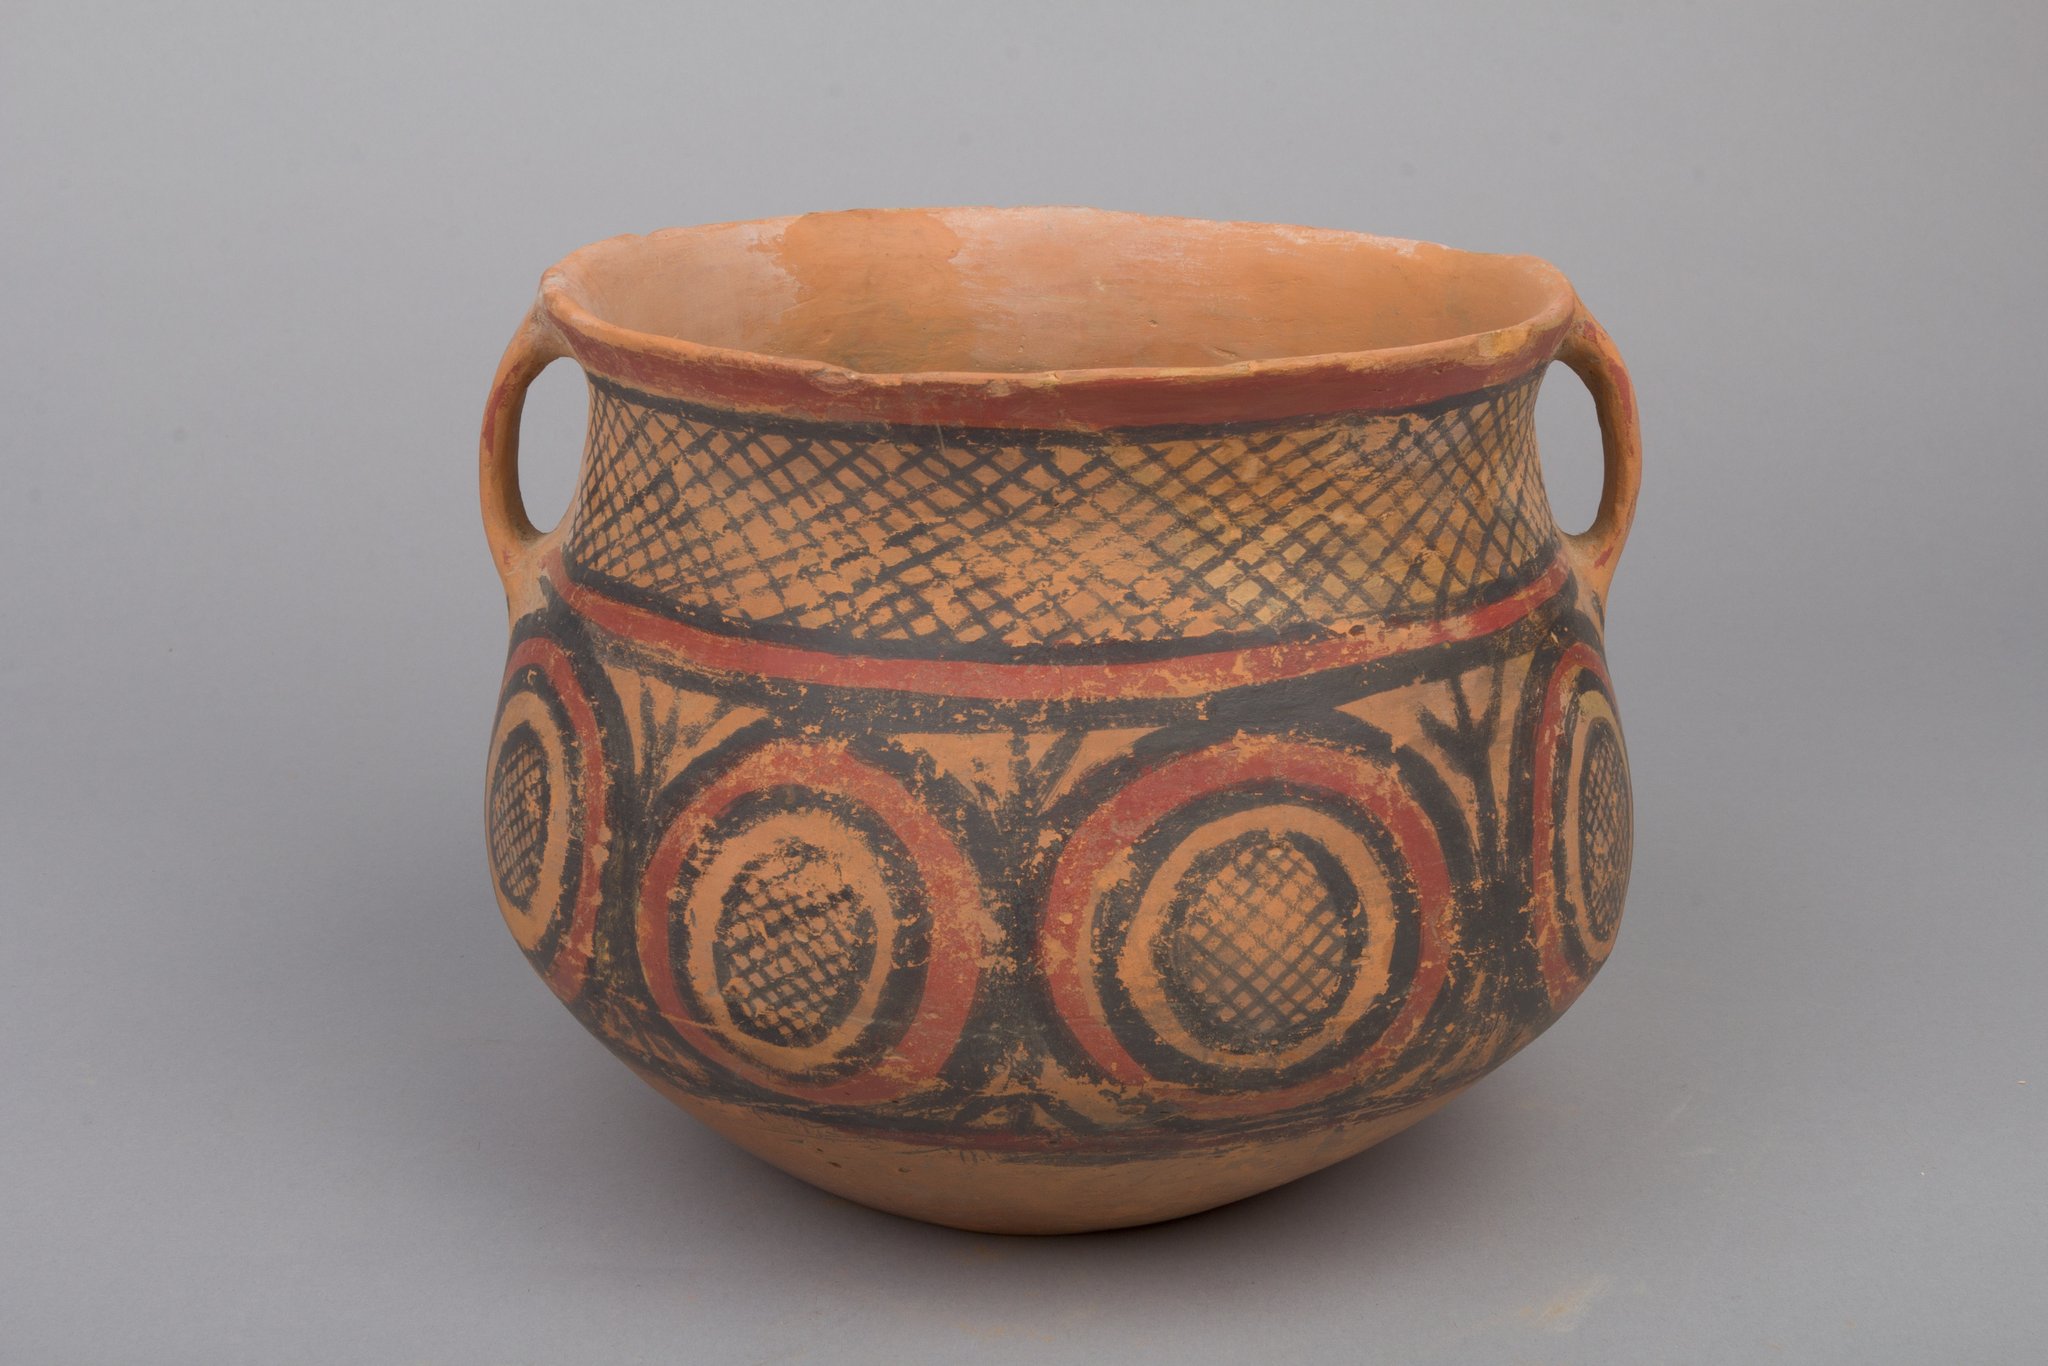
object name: jar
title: Jar with Spiral Decoration and Cross Hatching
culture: chinese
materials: earthenware, pigment